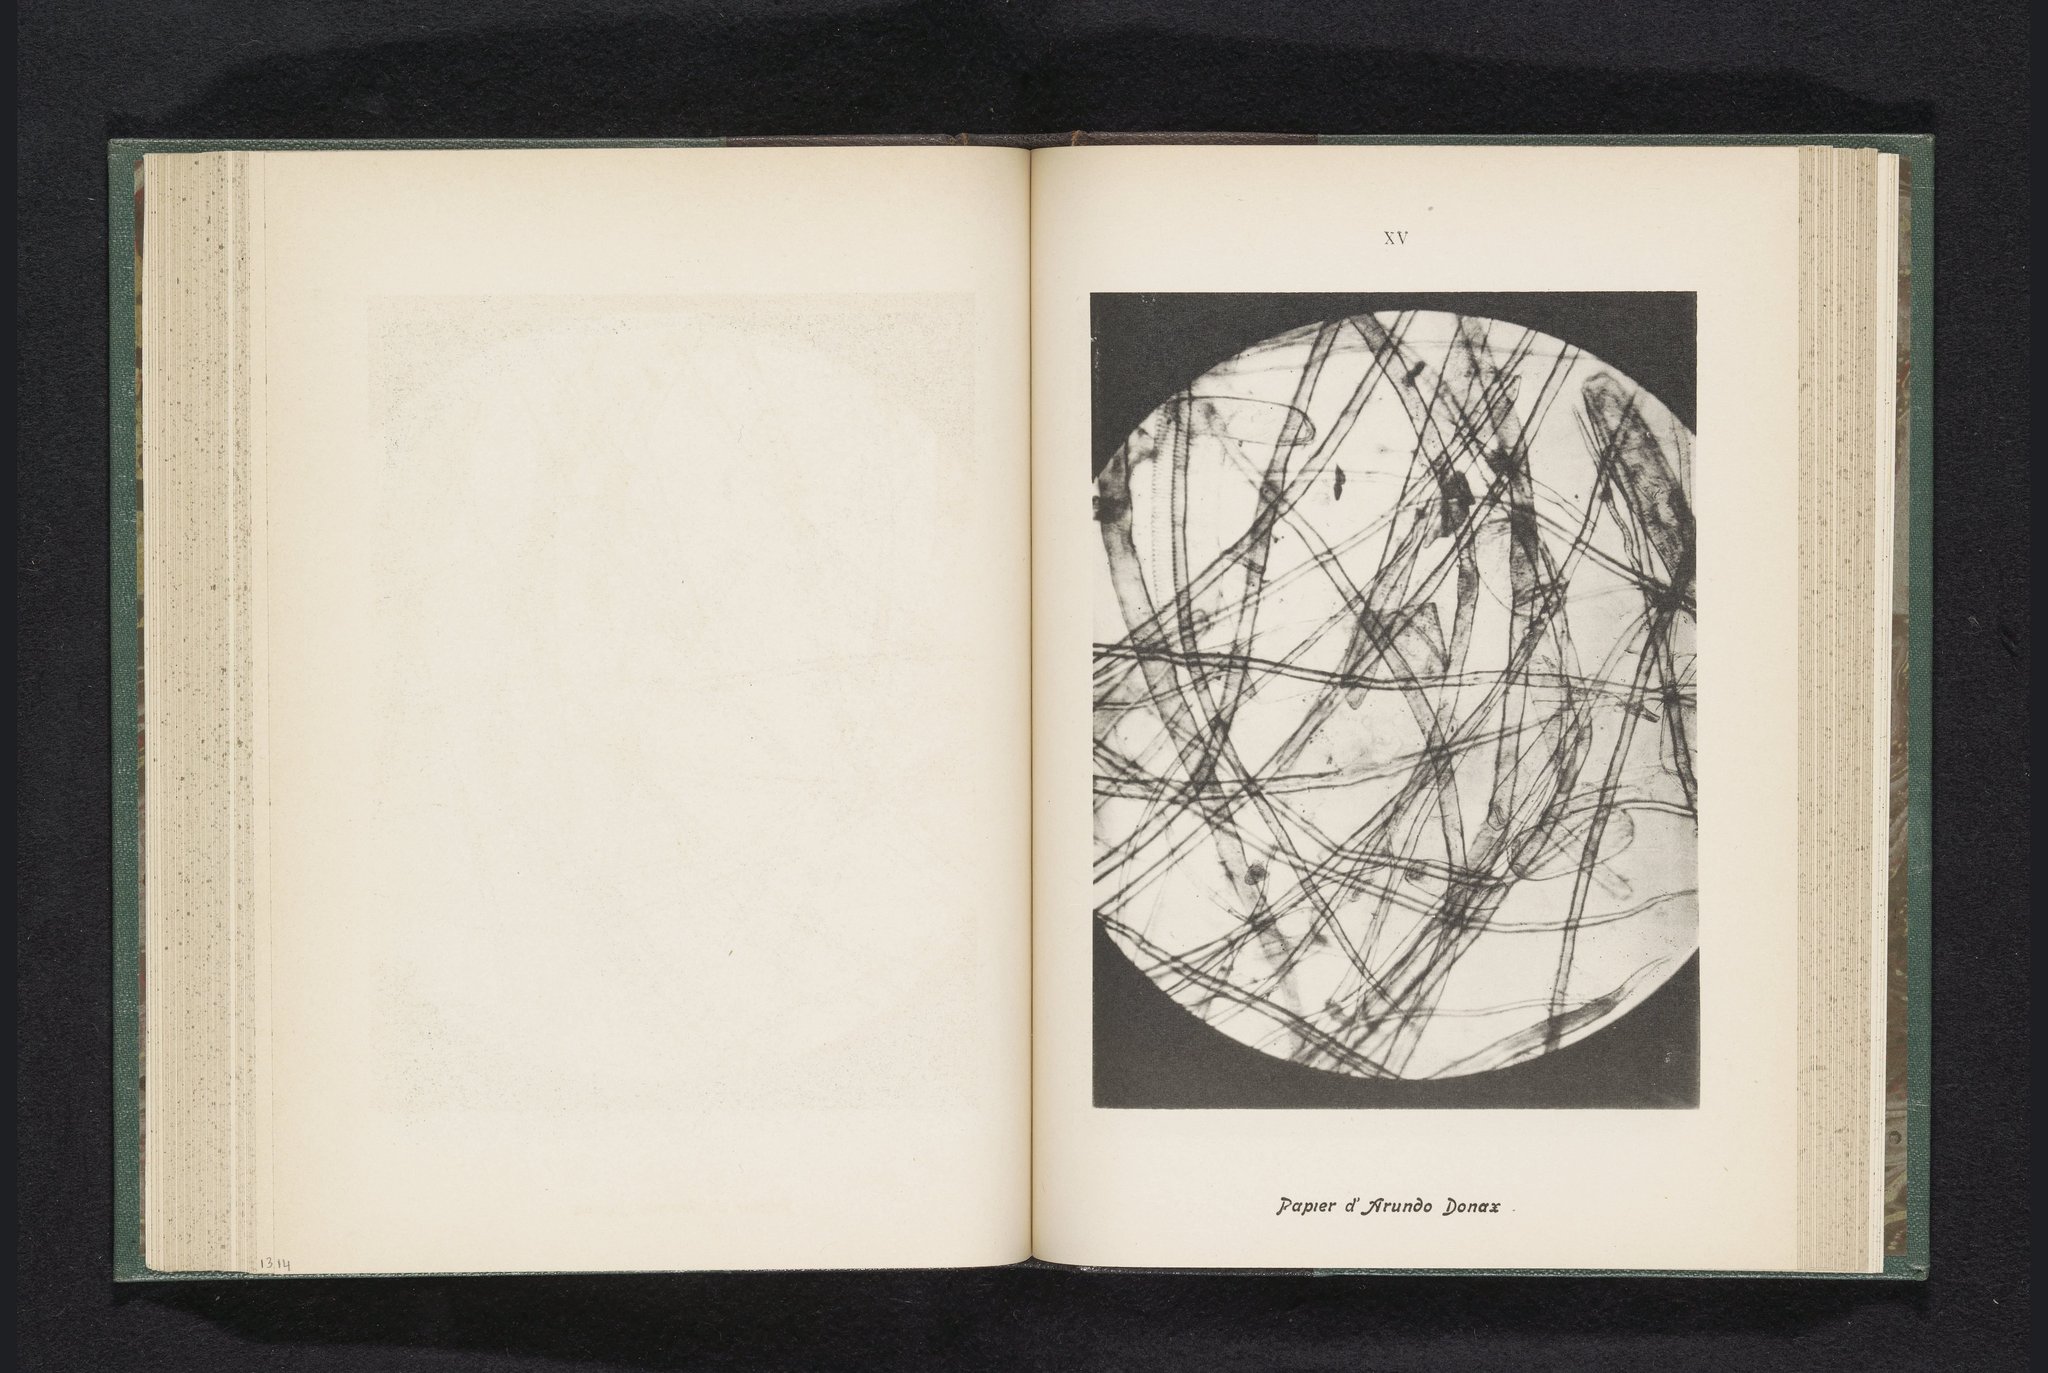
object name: photomechanical print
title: Micro-opname van de vezels in papier van pijlriet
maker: Anonymous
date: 1890-1900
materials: paper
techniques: photograph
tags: plants and herbs: reed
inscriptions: number: ‘XV’